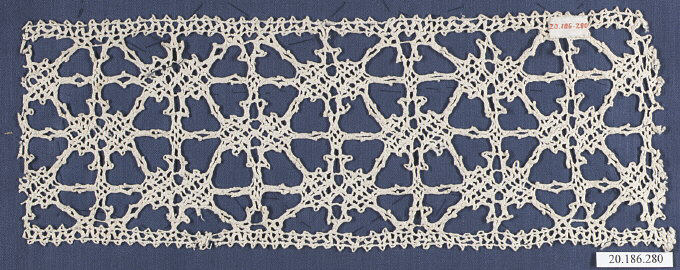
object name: insertion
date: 1501-1600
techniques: lace